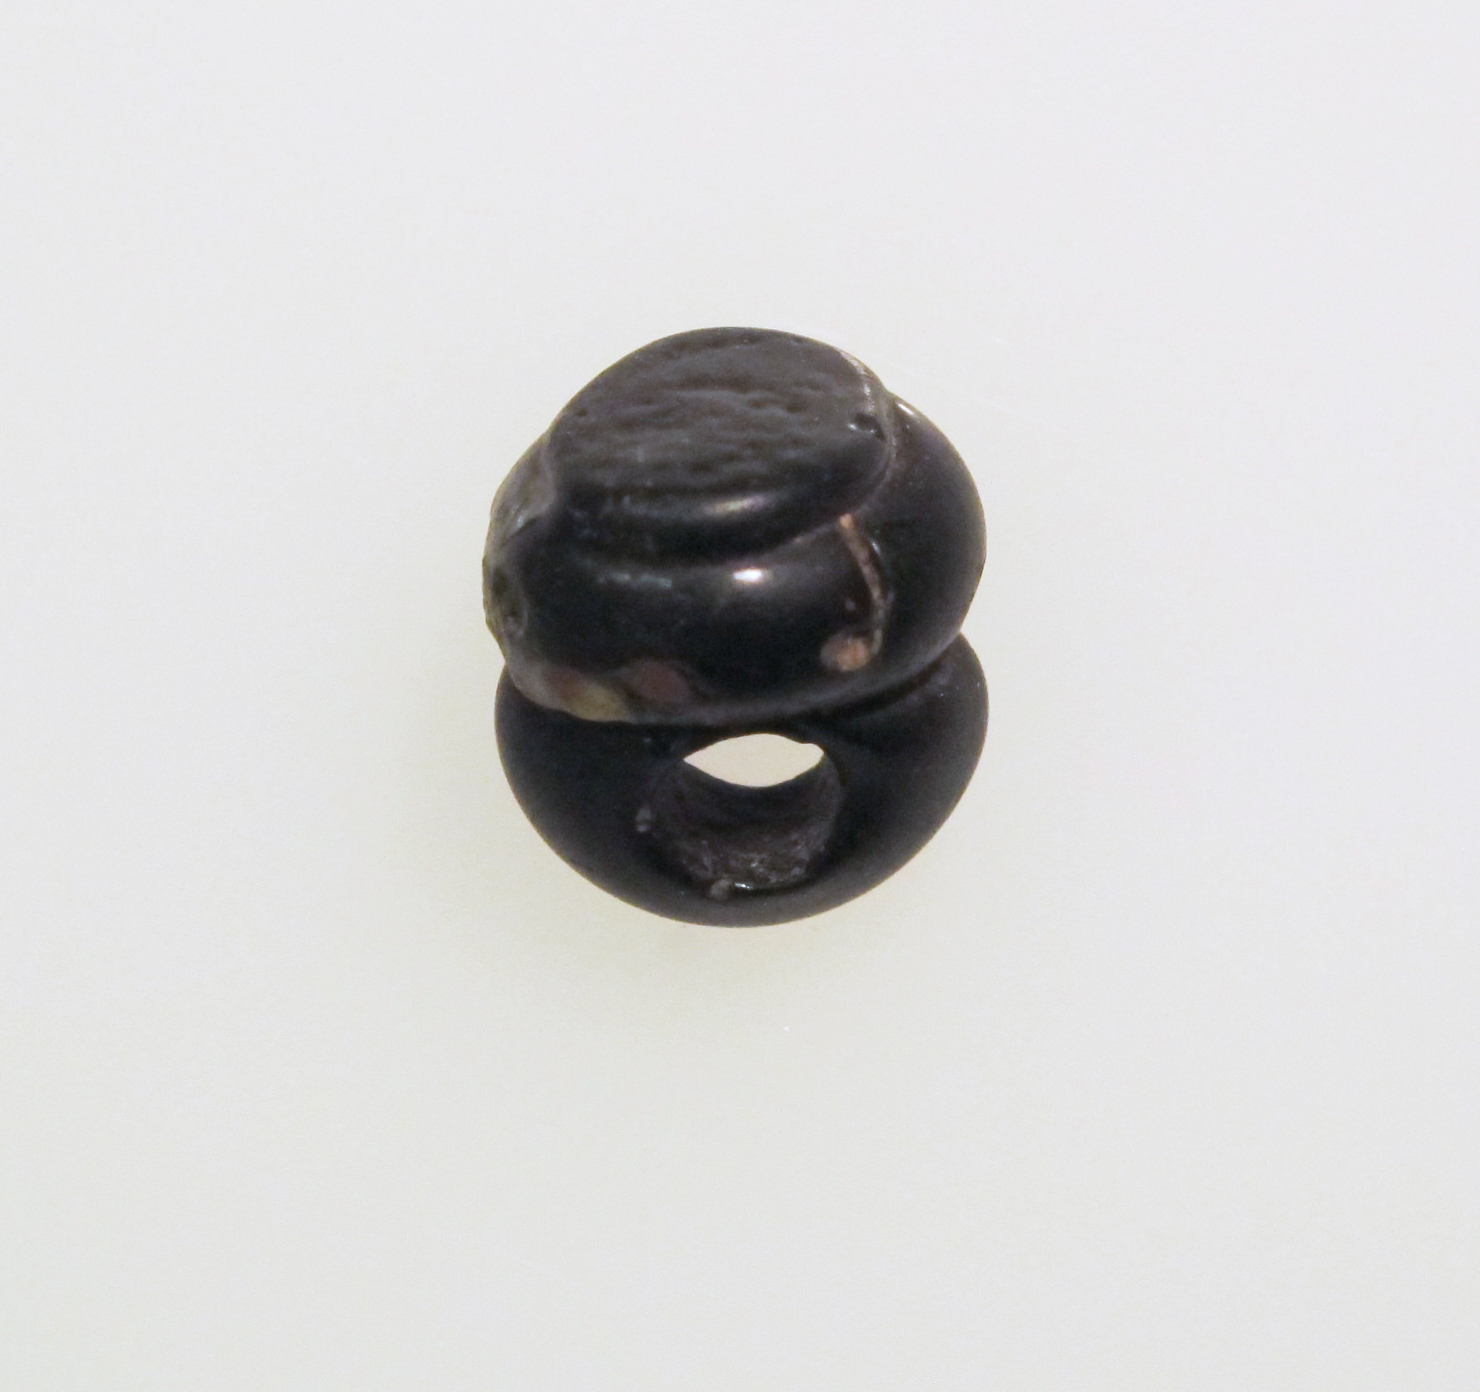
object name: pendant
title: Glass pendant shaped like a jar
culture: roman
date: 201-400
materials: glass